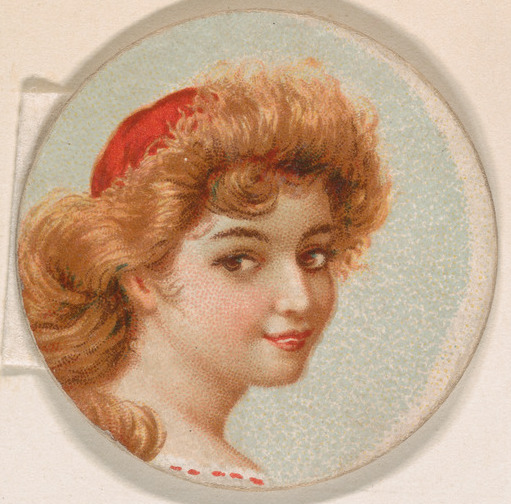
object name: print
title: Portrait of woman, from the Novelties series (N228, Type 1) issued by Kinney Bros.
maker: kinney brothers tobacco company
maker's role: publisher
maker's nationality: american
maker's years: 1869-2011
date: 1889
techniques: color lithograph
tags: portraits,women